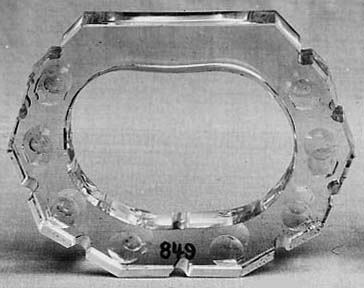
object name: ring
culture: chinese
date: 1701-1800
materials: quartz